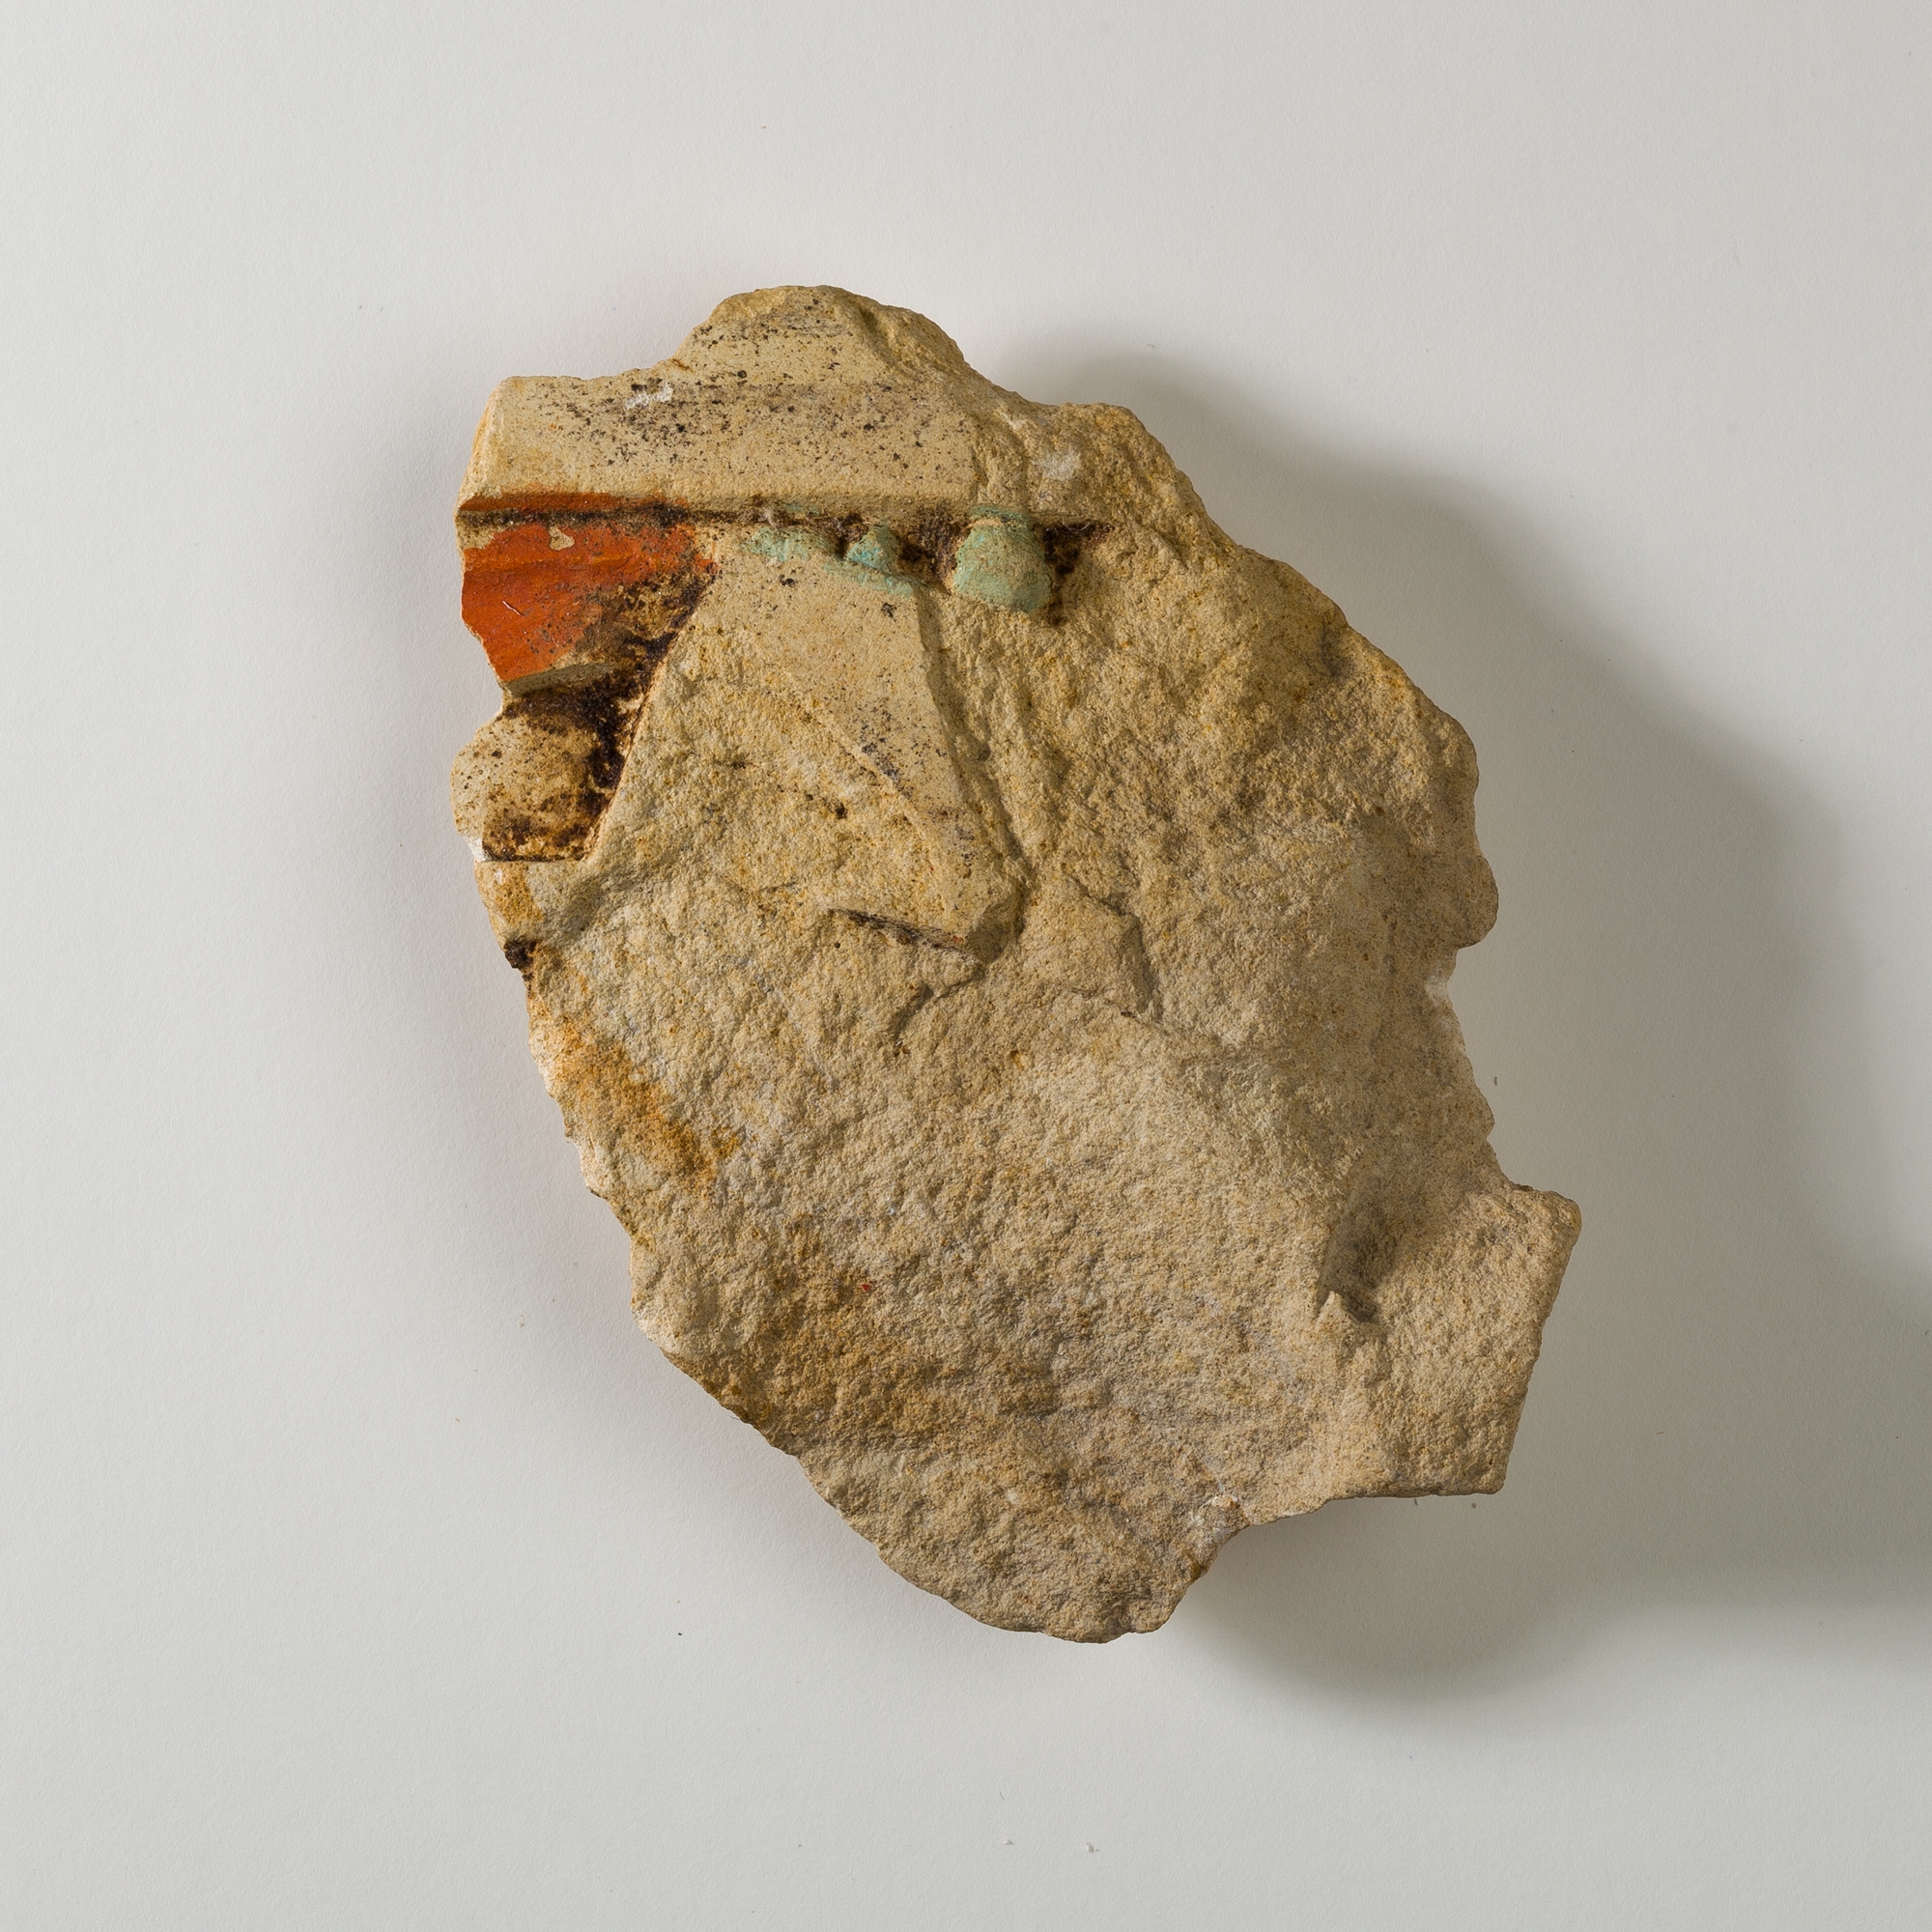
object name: relief fragment, neferu or khety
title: Relief Fragment from the Tomb of Neferu or Khety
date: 2030-1640 BCE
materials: limestone, paint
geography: egypt